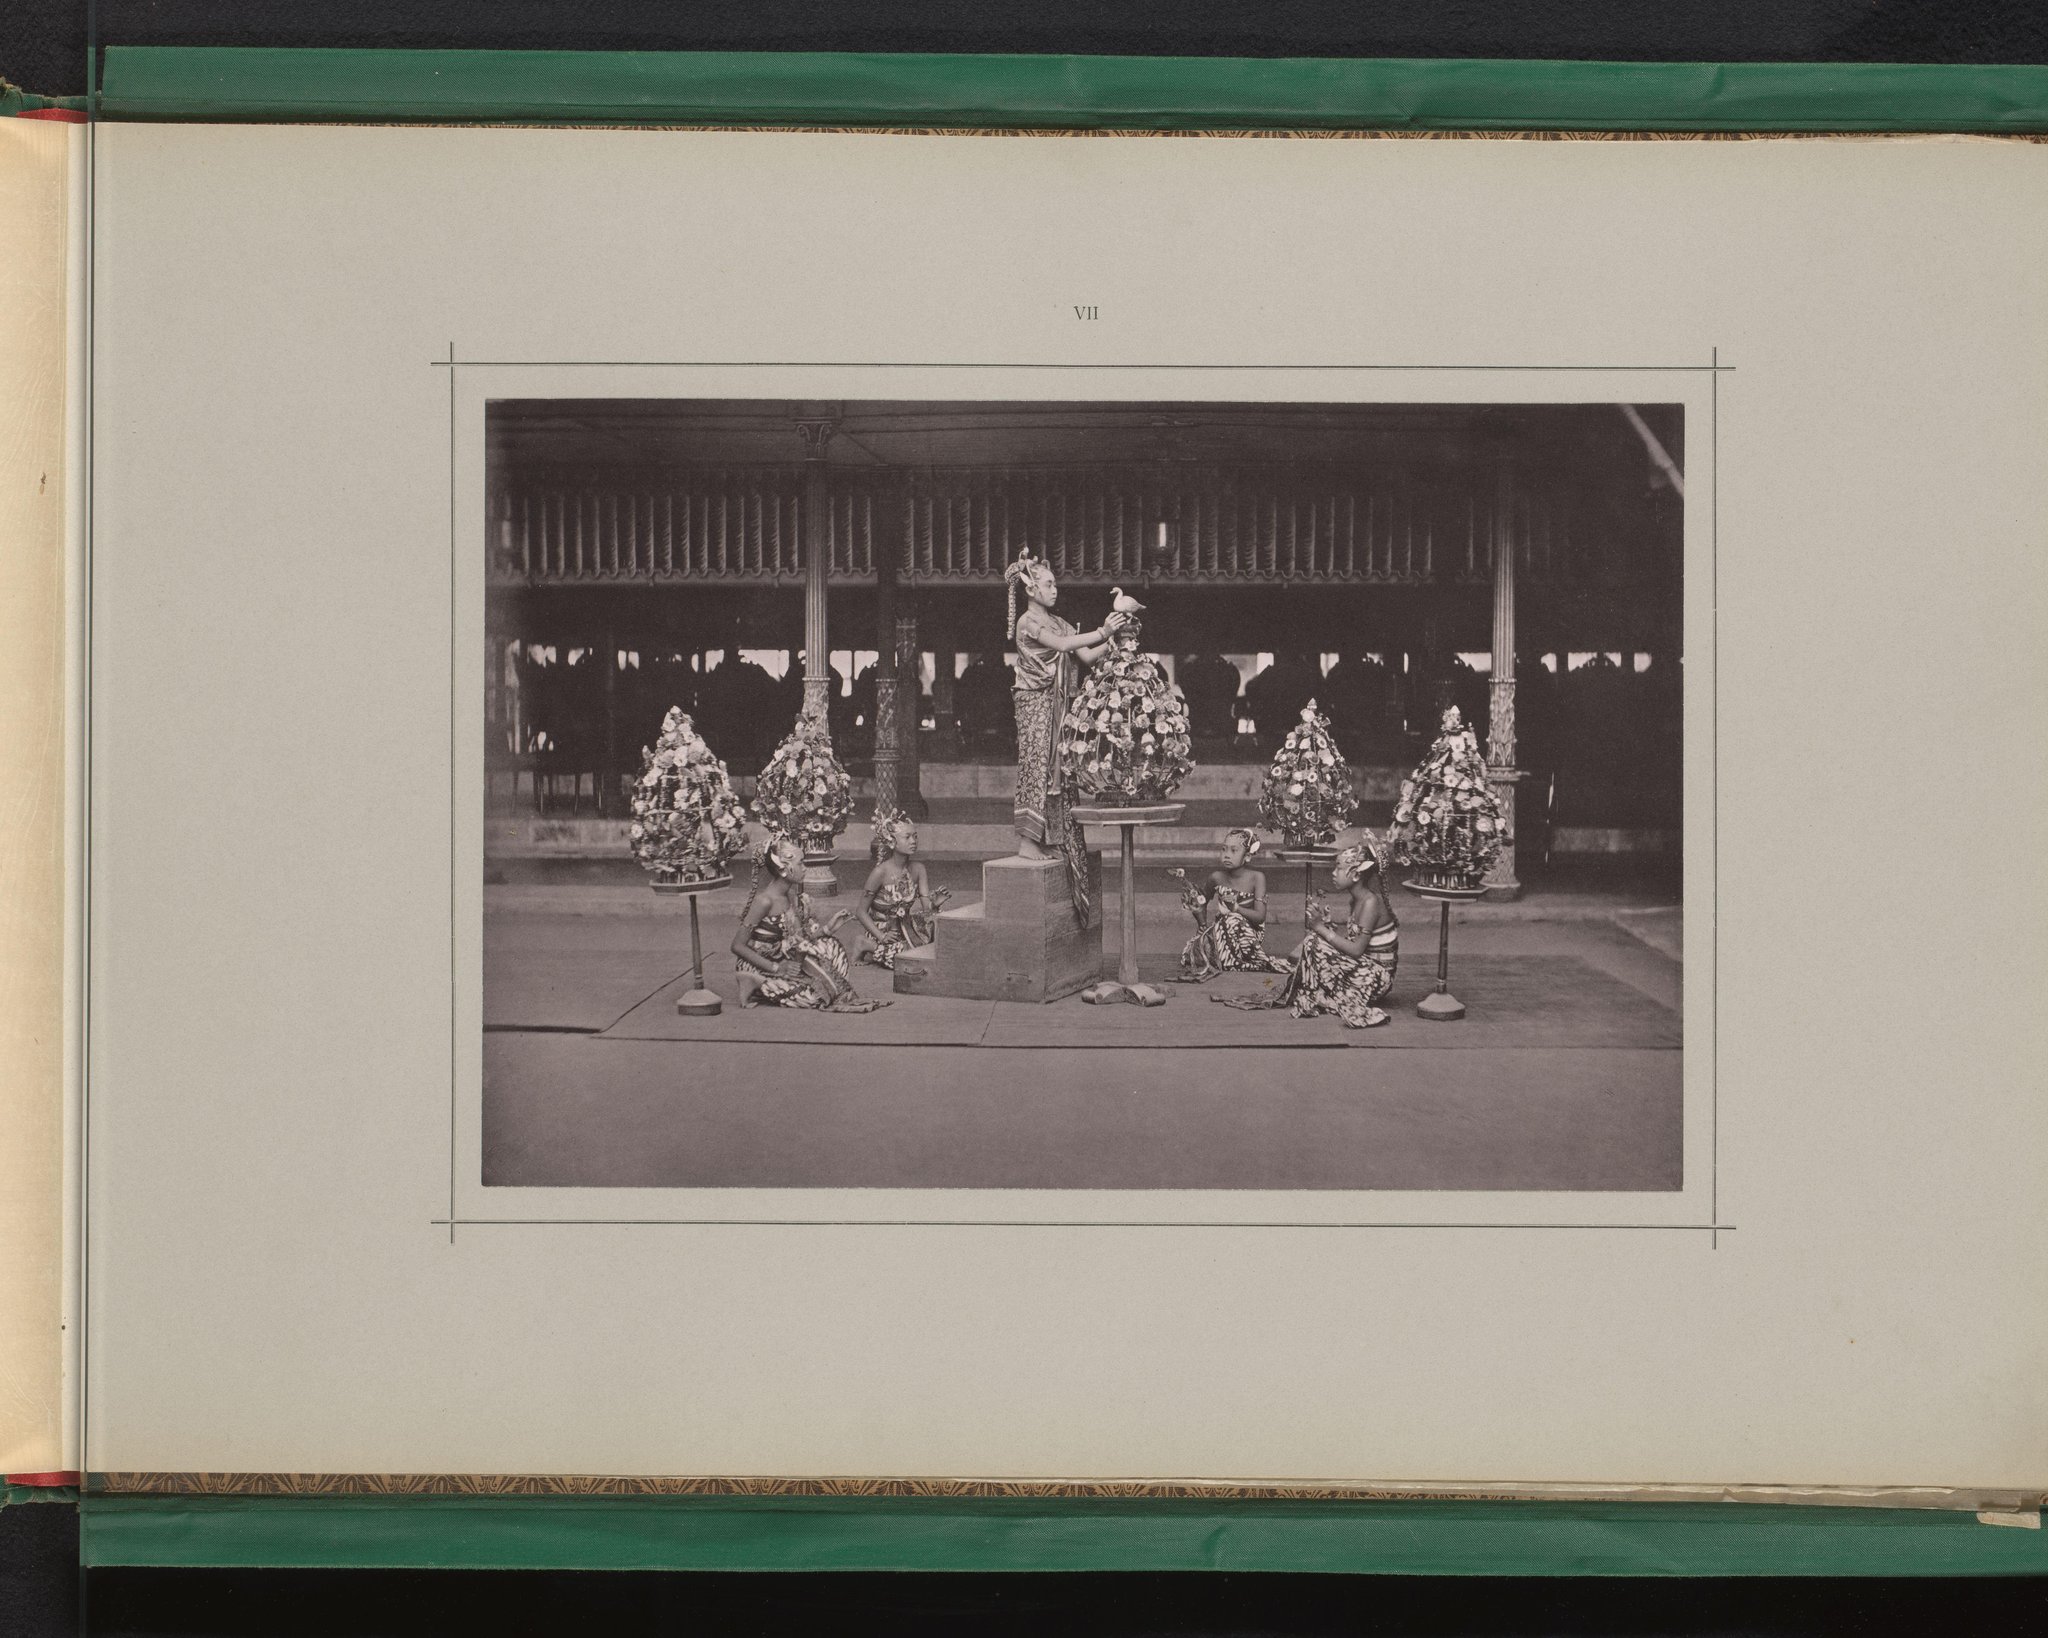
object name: photomechanical print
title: Vijf jonge vrouwen voeren een toneelstuk op in de Kraton Ngayogyakarta Hadiningrat in Jogyakarta, Indonesië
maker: kassian céphas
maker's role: fotograaf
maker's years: 1845-1912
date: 1883-1888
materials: paper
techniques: photograph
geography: yogyakarta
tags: group of actors, troupe; actors on the stage, adolescent, young woman, maiden (+ five persons)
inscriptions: number: ‘VII’